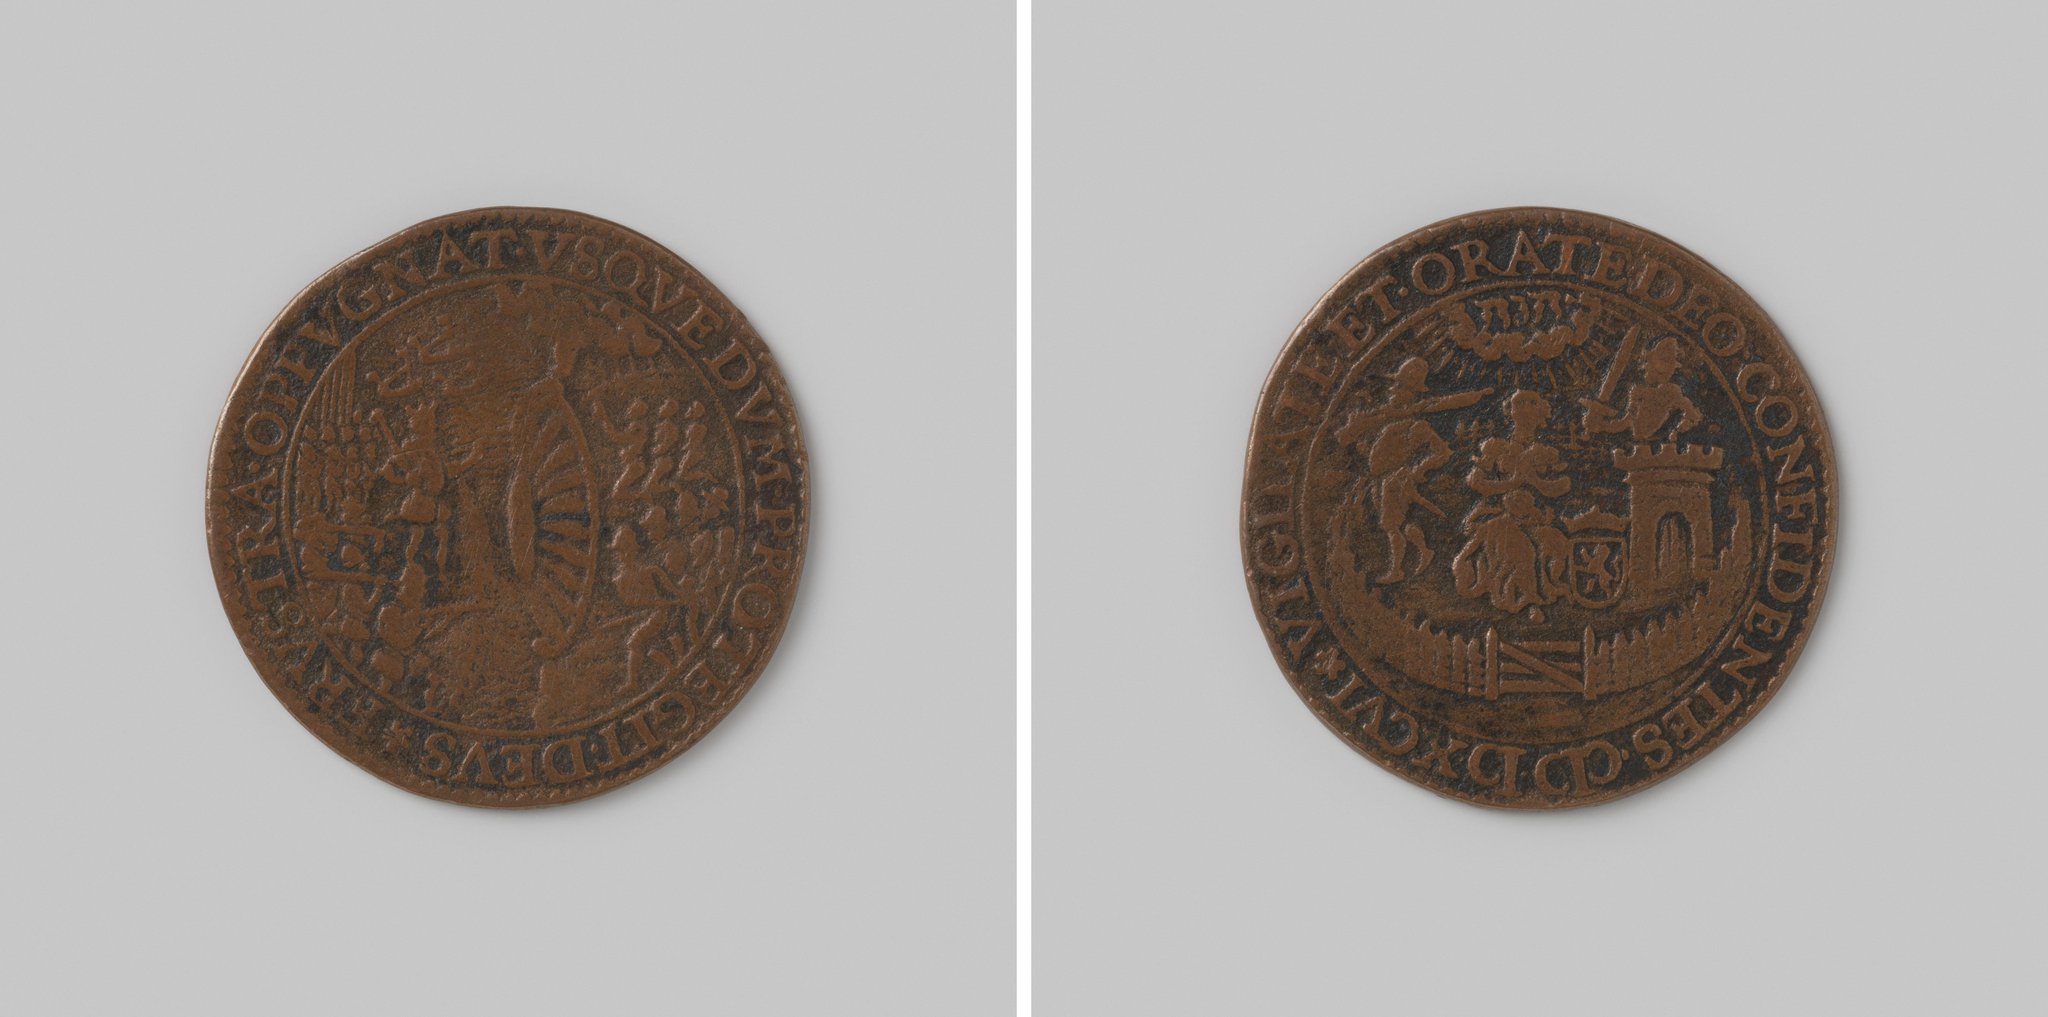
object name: jeton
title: Rekenpenning uit Dordrecht op de bedreiging van Zeeland door Aartshertog Albertus van Oostenrijk 1596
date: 1596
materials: copper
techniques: striking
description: Koperen penning, op de voorzijde twee legers gescheiden door water, het rechter beschermd door een schild uit de hemel, met omschrift, op de keerzijde de Hollandse Maagd in een tuin beschermd door soldaten, onder de stralende naam Gods, met omschrift.